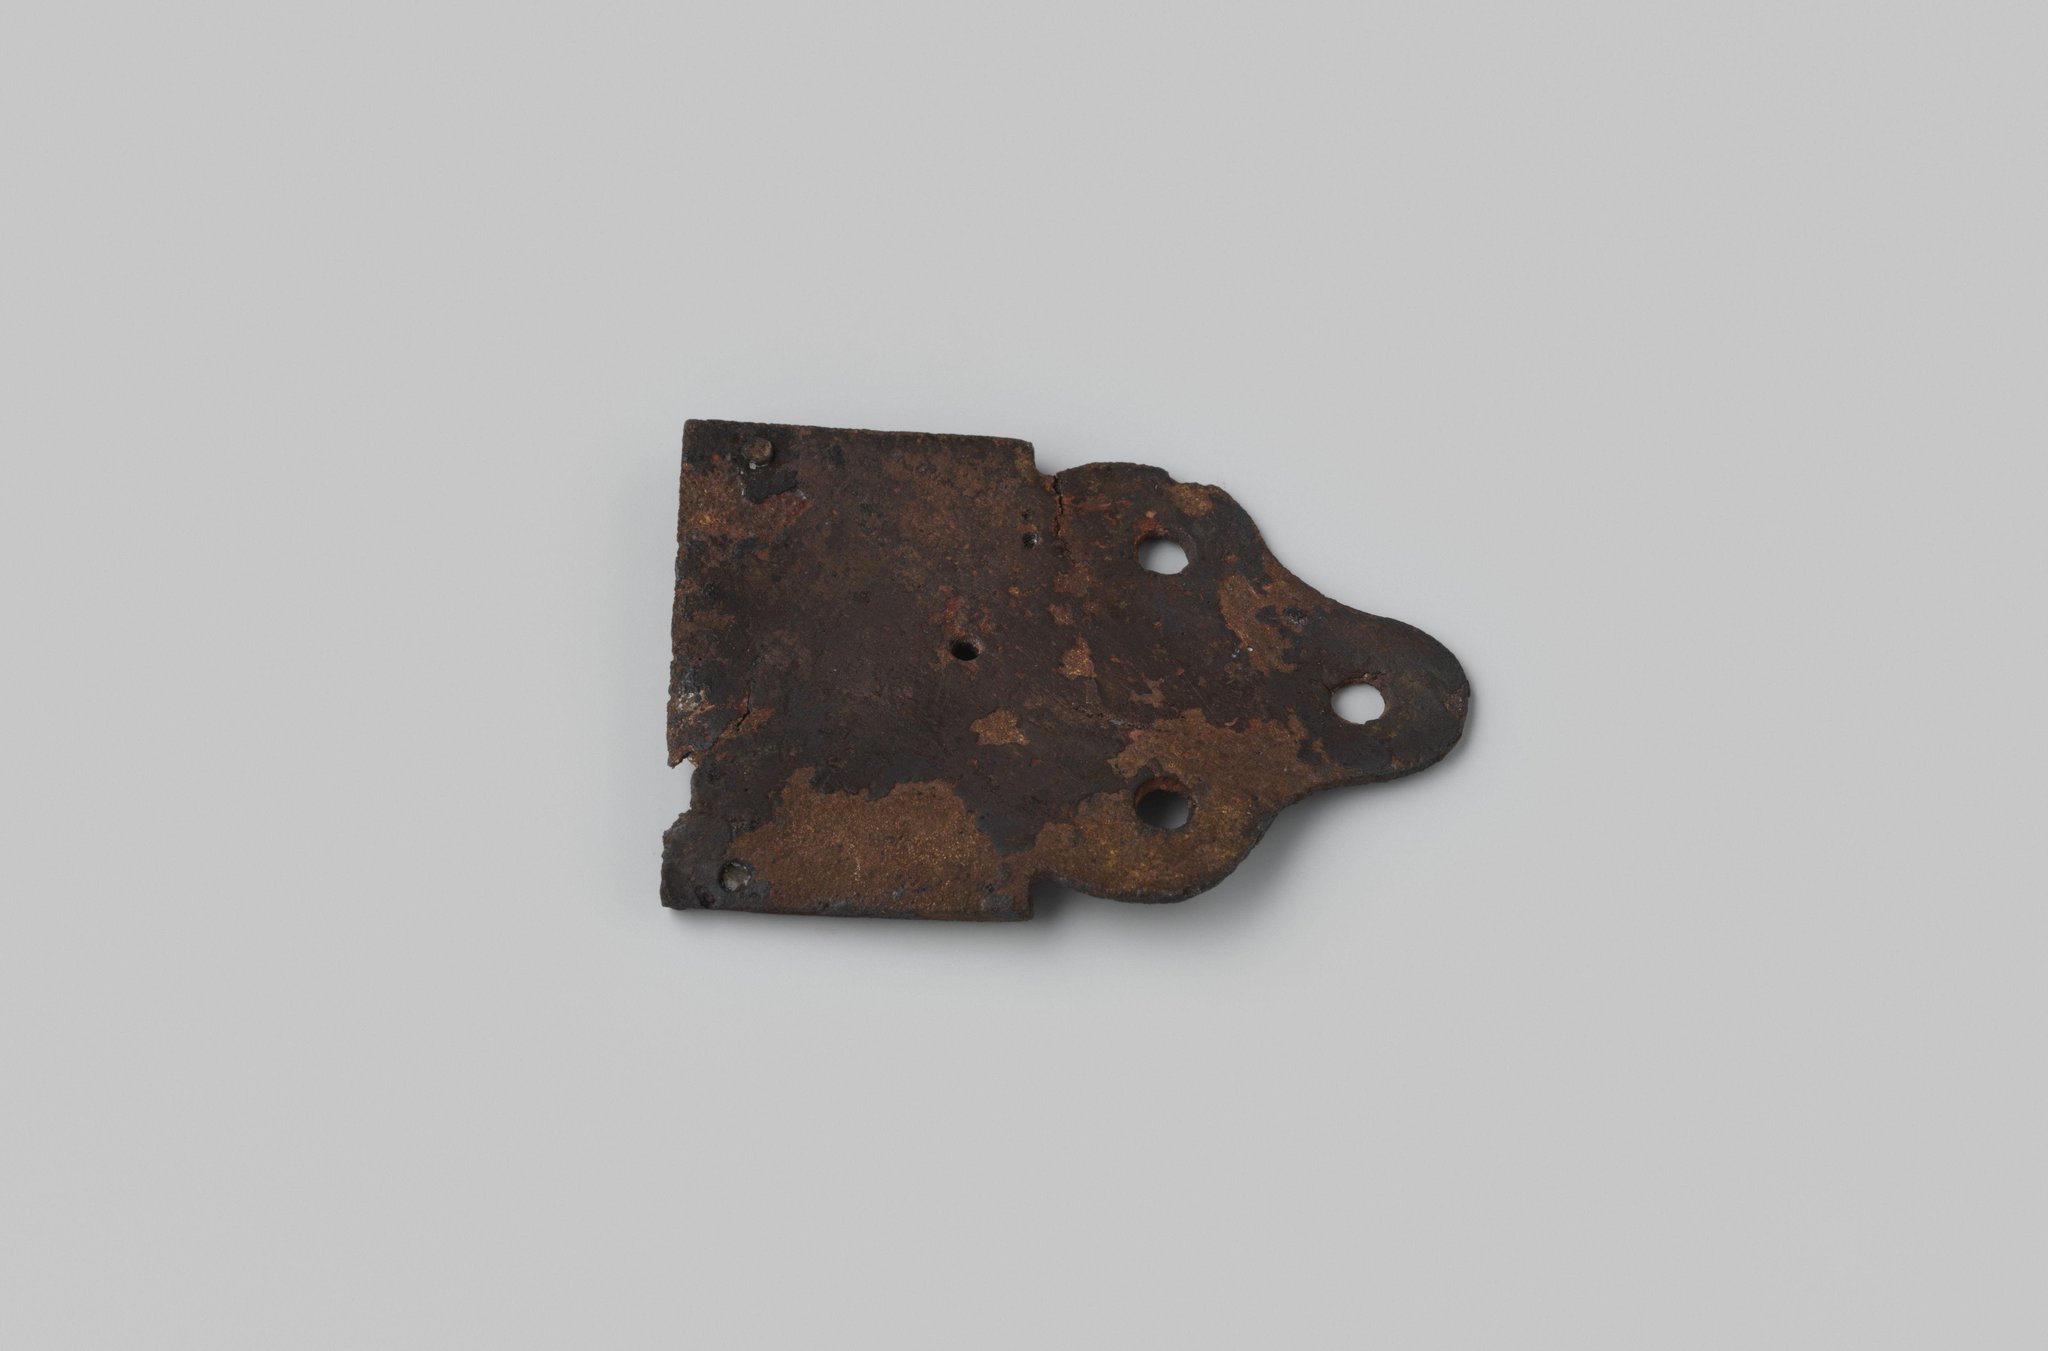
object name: lock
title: Deel van een slot uit het wrak van de Oost-Indiëvaarder Hollandia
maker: Anonymous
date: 1700-1743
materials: copper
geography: netherlands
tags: verenigde oostindische compagnie, hollandia (schip), annet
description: Locks, fastenings and accessories. lock: casings; fragm, back-plate, sim. NG 1980-27H559, 1 central peg missing, ass. NG 1980-27H561/863x.